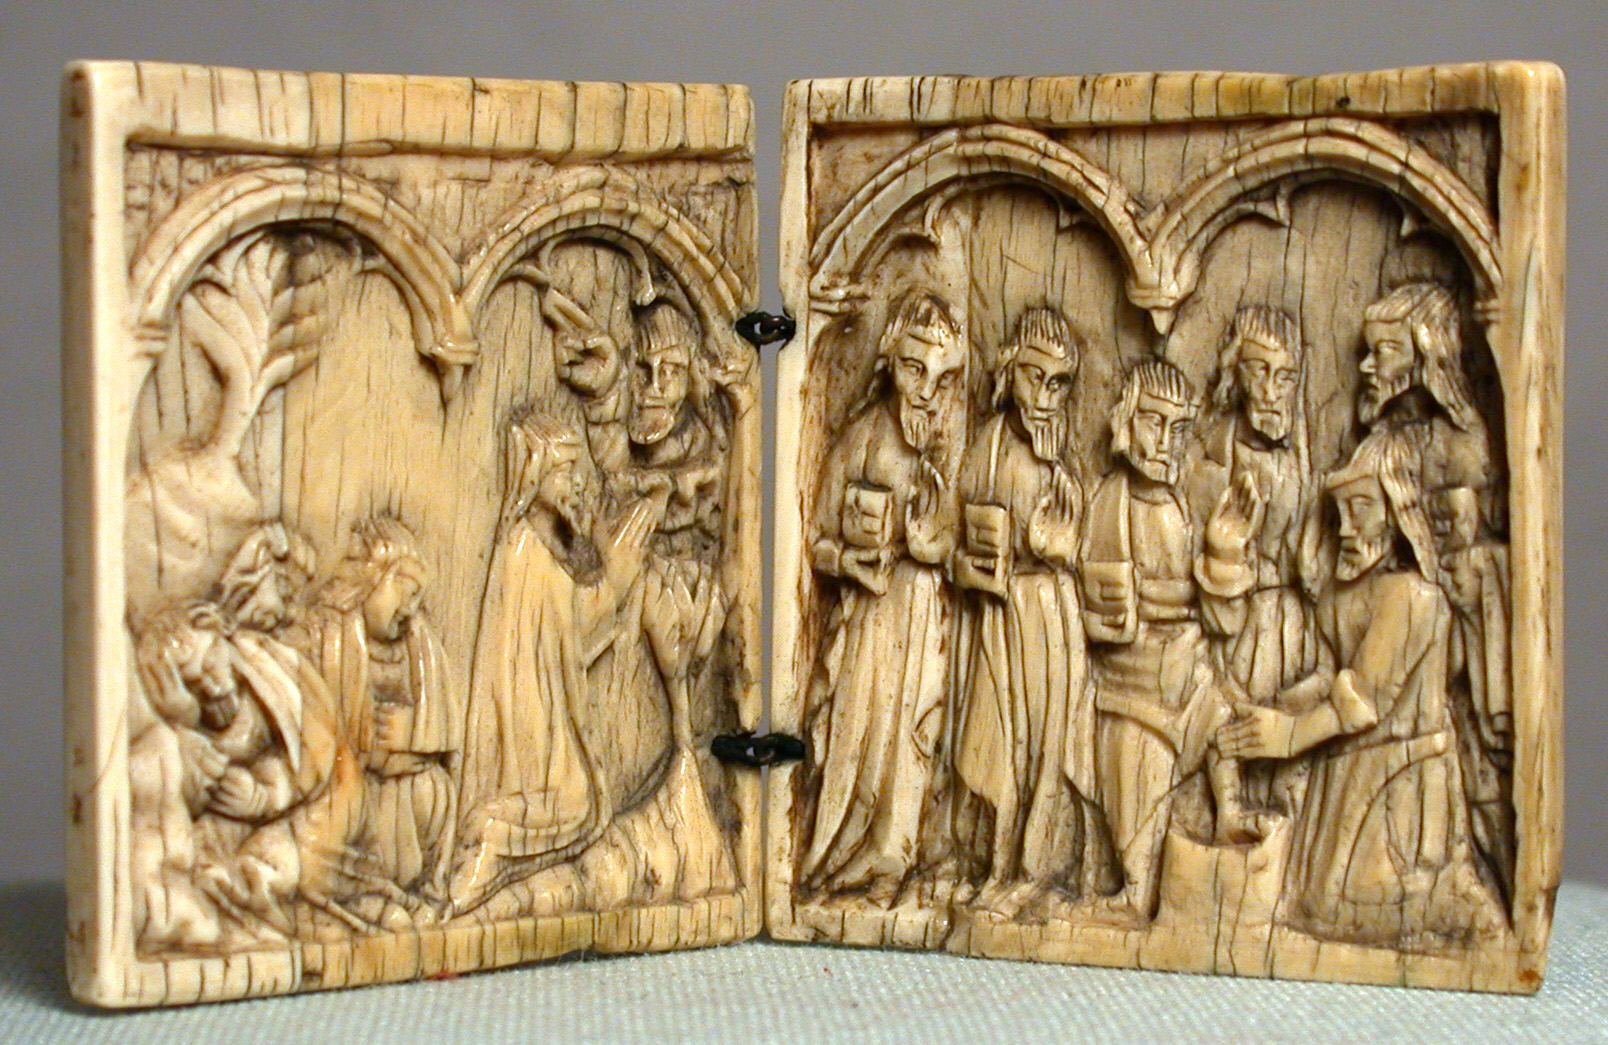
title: Diptych with Scenes from the Passion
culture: french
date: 1401-1500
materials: iron, ivory